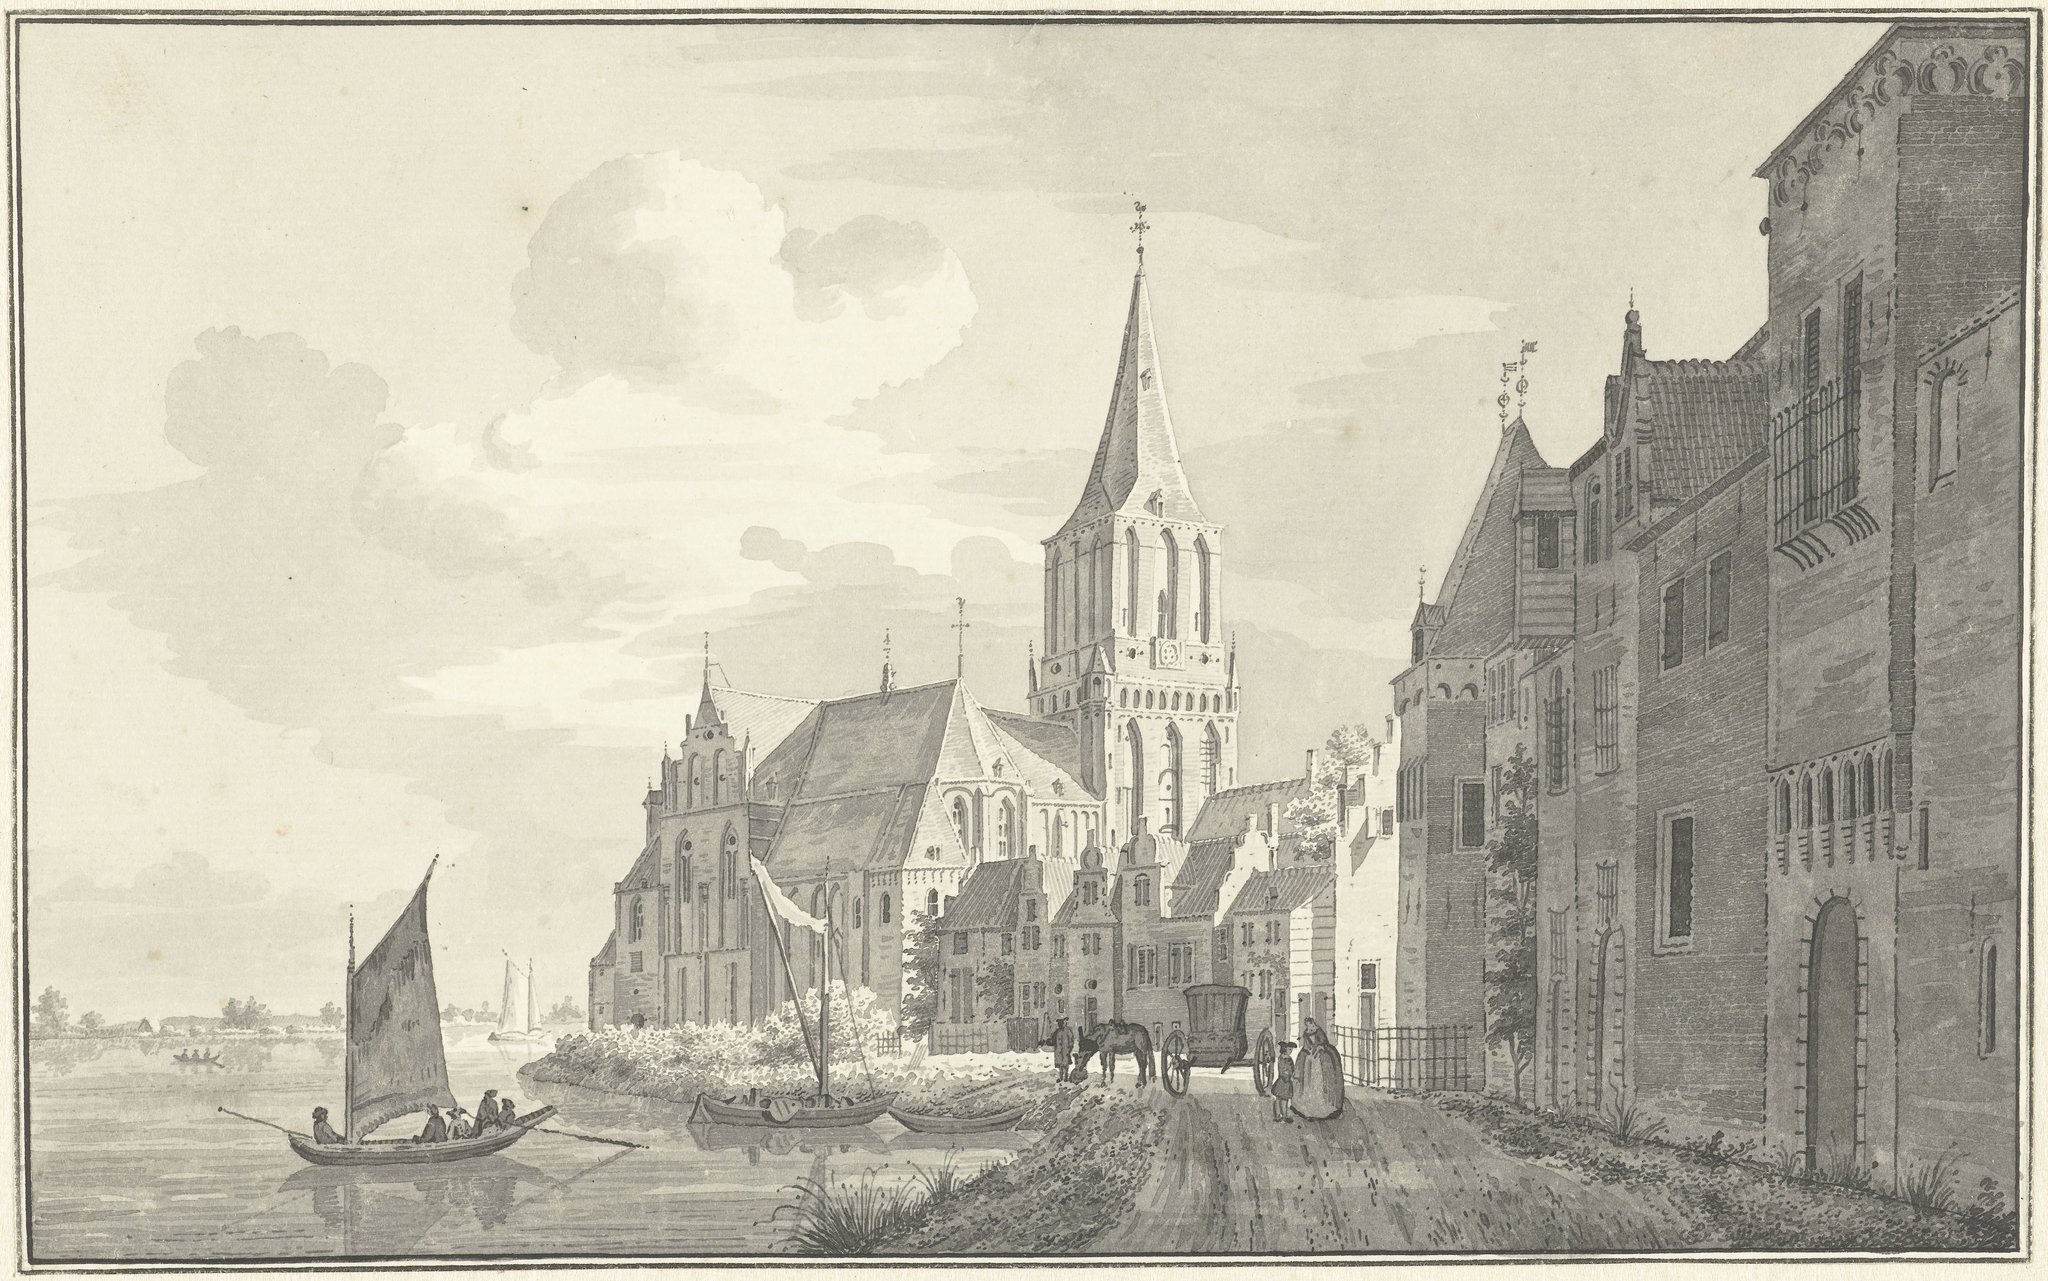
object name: drawing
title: De Munster Kerk te Emmerich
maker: pieter jan van liender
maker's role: print maker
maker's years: 1727-1779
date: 1752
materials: ink, paper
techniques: brush, pen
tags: church (exterior), germany